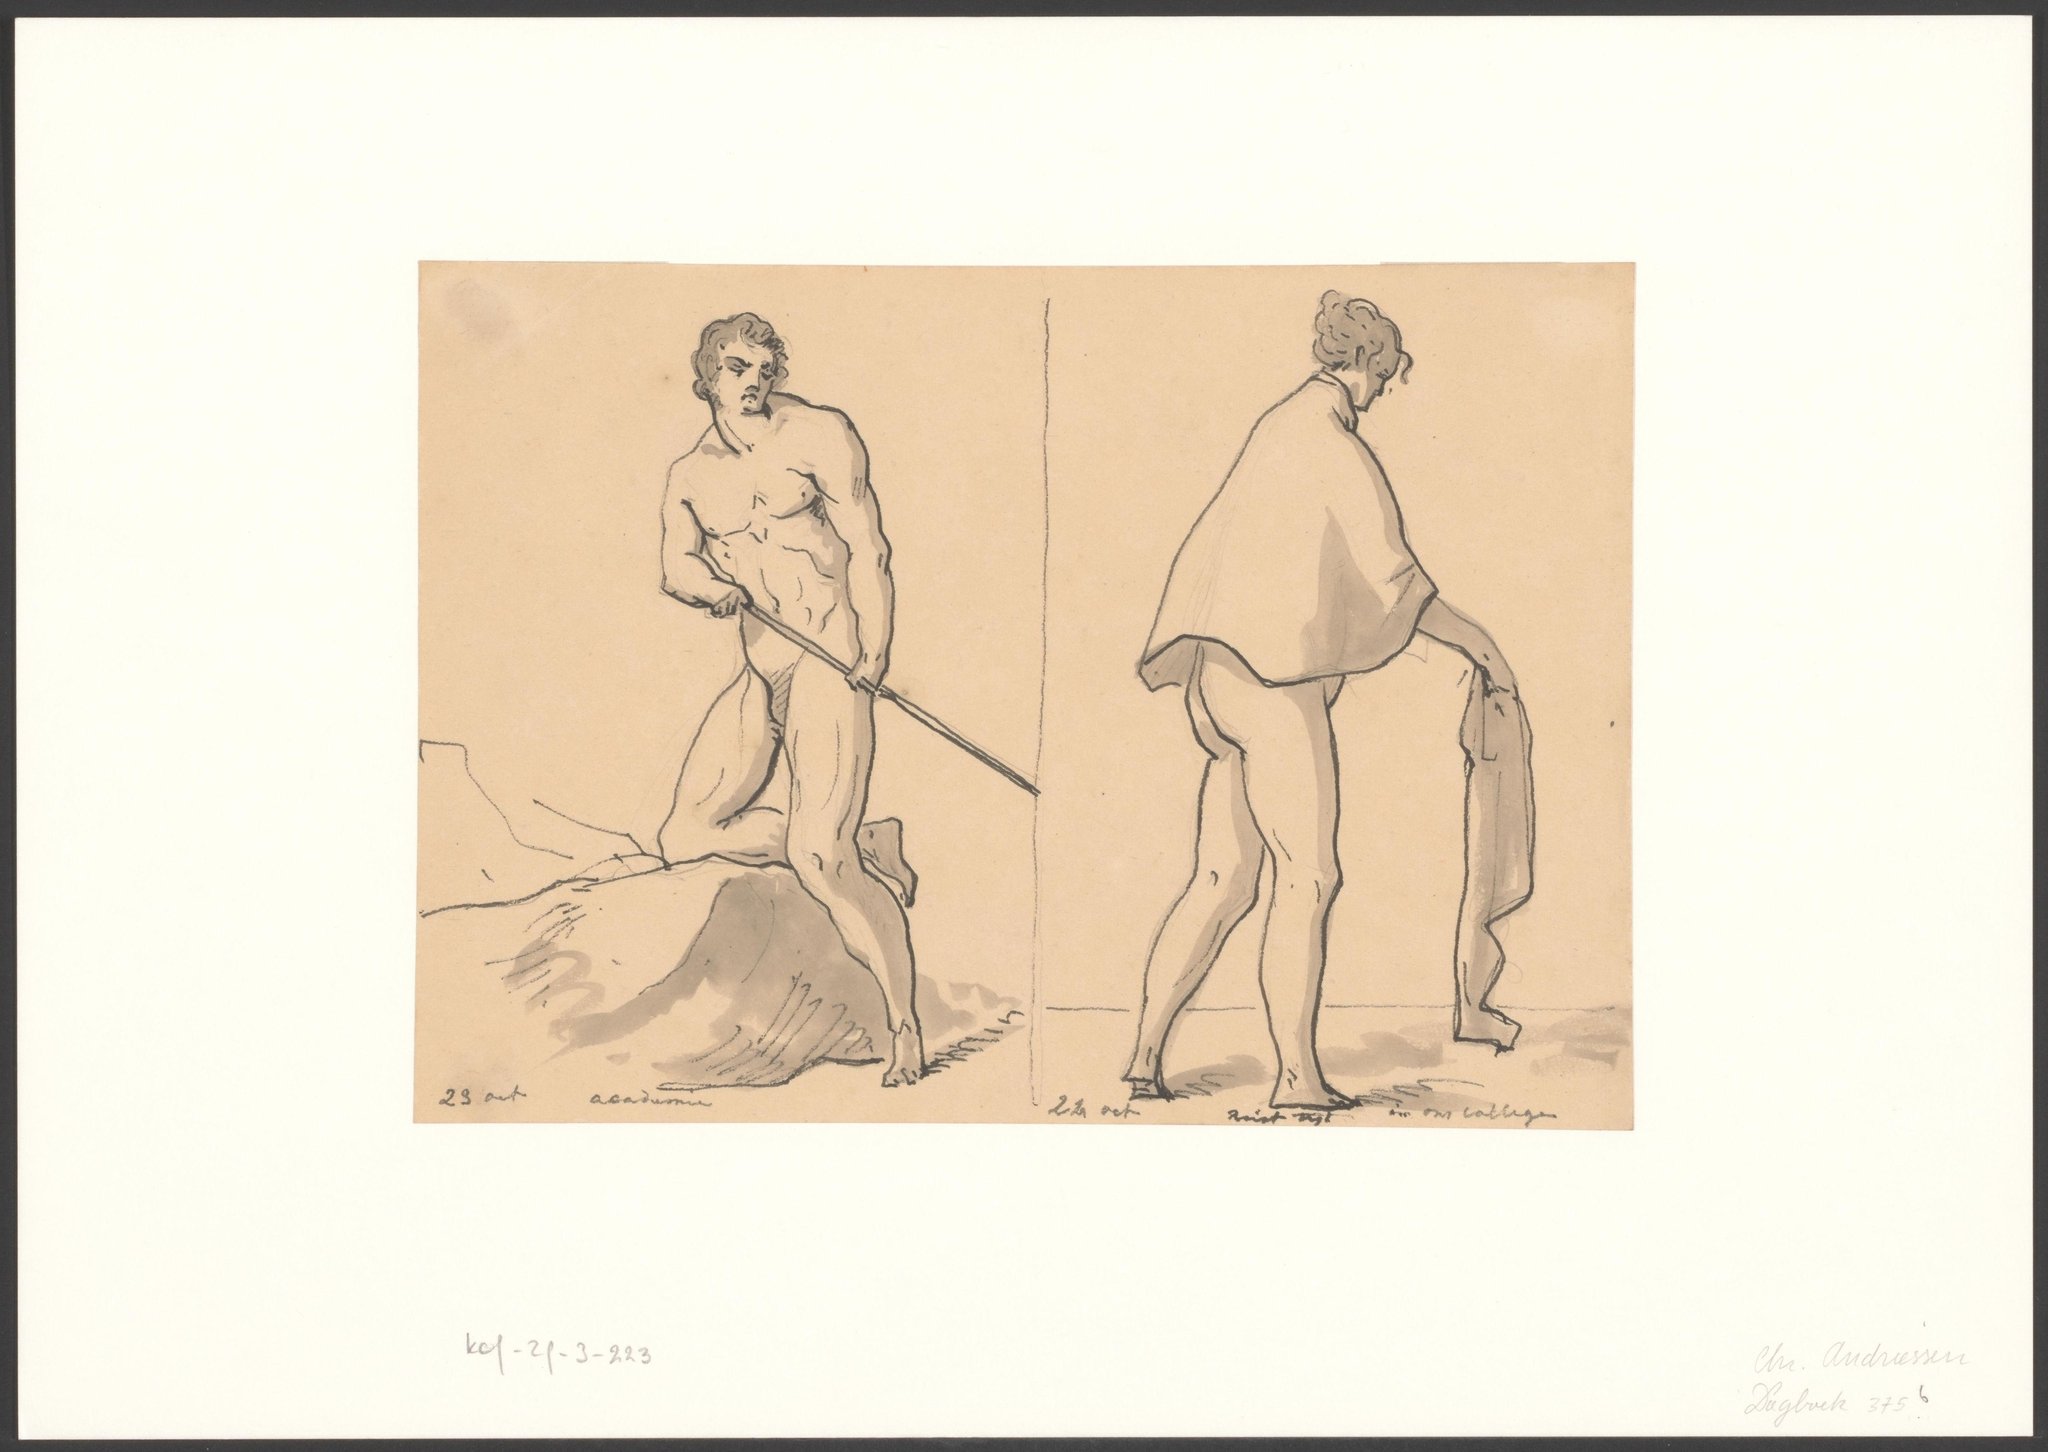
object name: drawing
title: Twee naaktmodellen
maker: christiaan andriessen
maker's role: draughtsman, print maker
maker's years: 1775-1846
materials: ink, paper, pencil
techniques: brush, pen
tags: amsterdam, print maker, draughtsman, christiaan andriessen, attempt to cover one's nakedness, model, mannequin, human figure of ideal proportions, e.g. academic nude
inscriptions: signature: ‘J Andriessen’, inscription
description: Tekeningen van 23 en 24 oktober 1805. Twee modellen op de tekenacademie. Links een mannelijk naaktmodel op de Tekenacademie. Rechts een vrouwelijk naaktmodel tijdens de pauze van het vrouwencollege bij de familie Andriessen thuis.